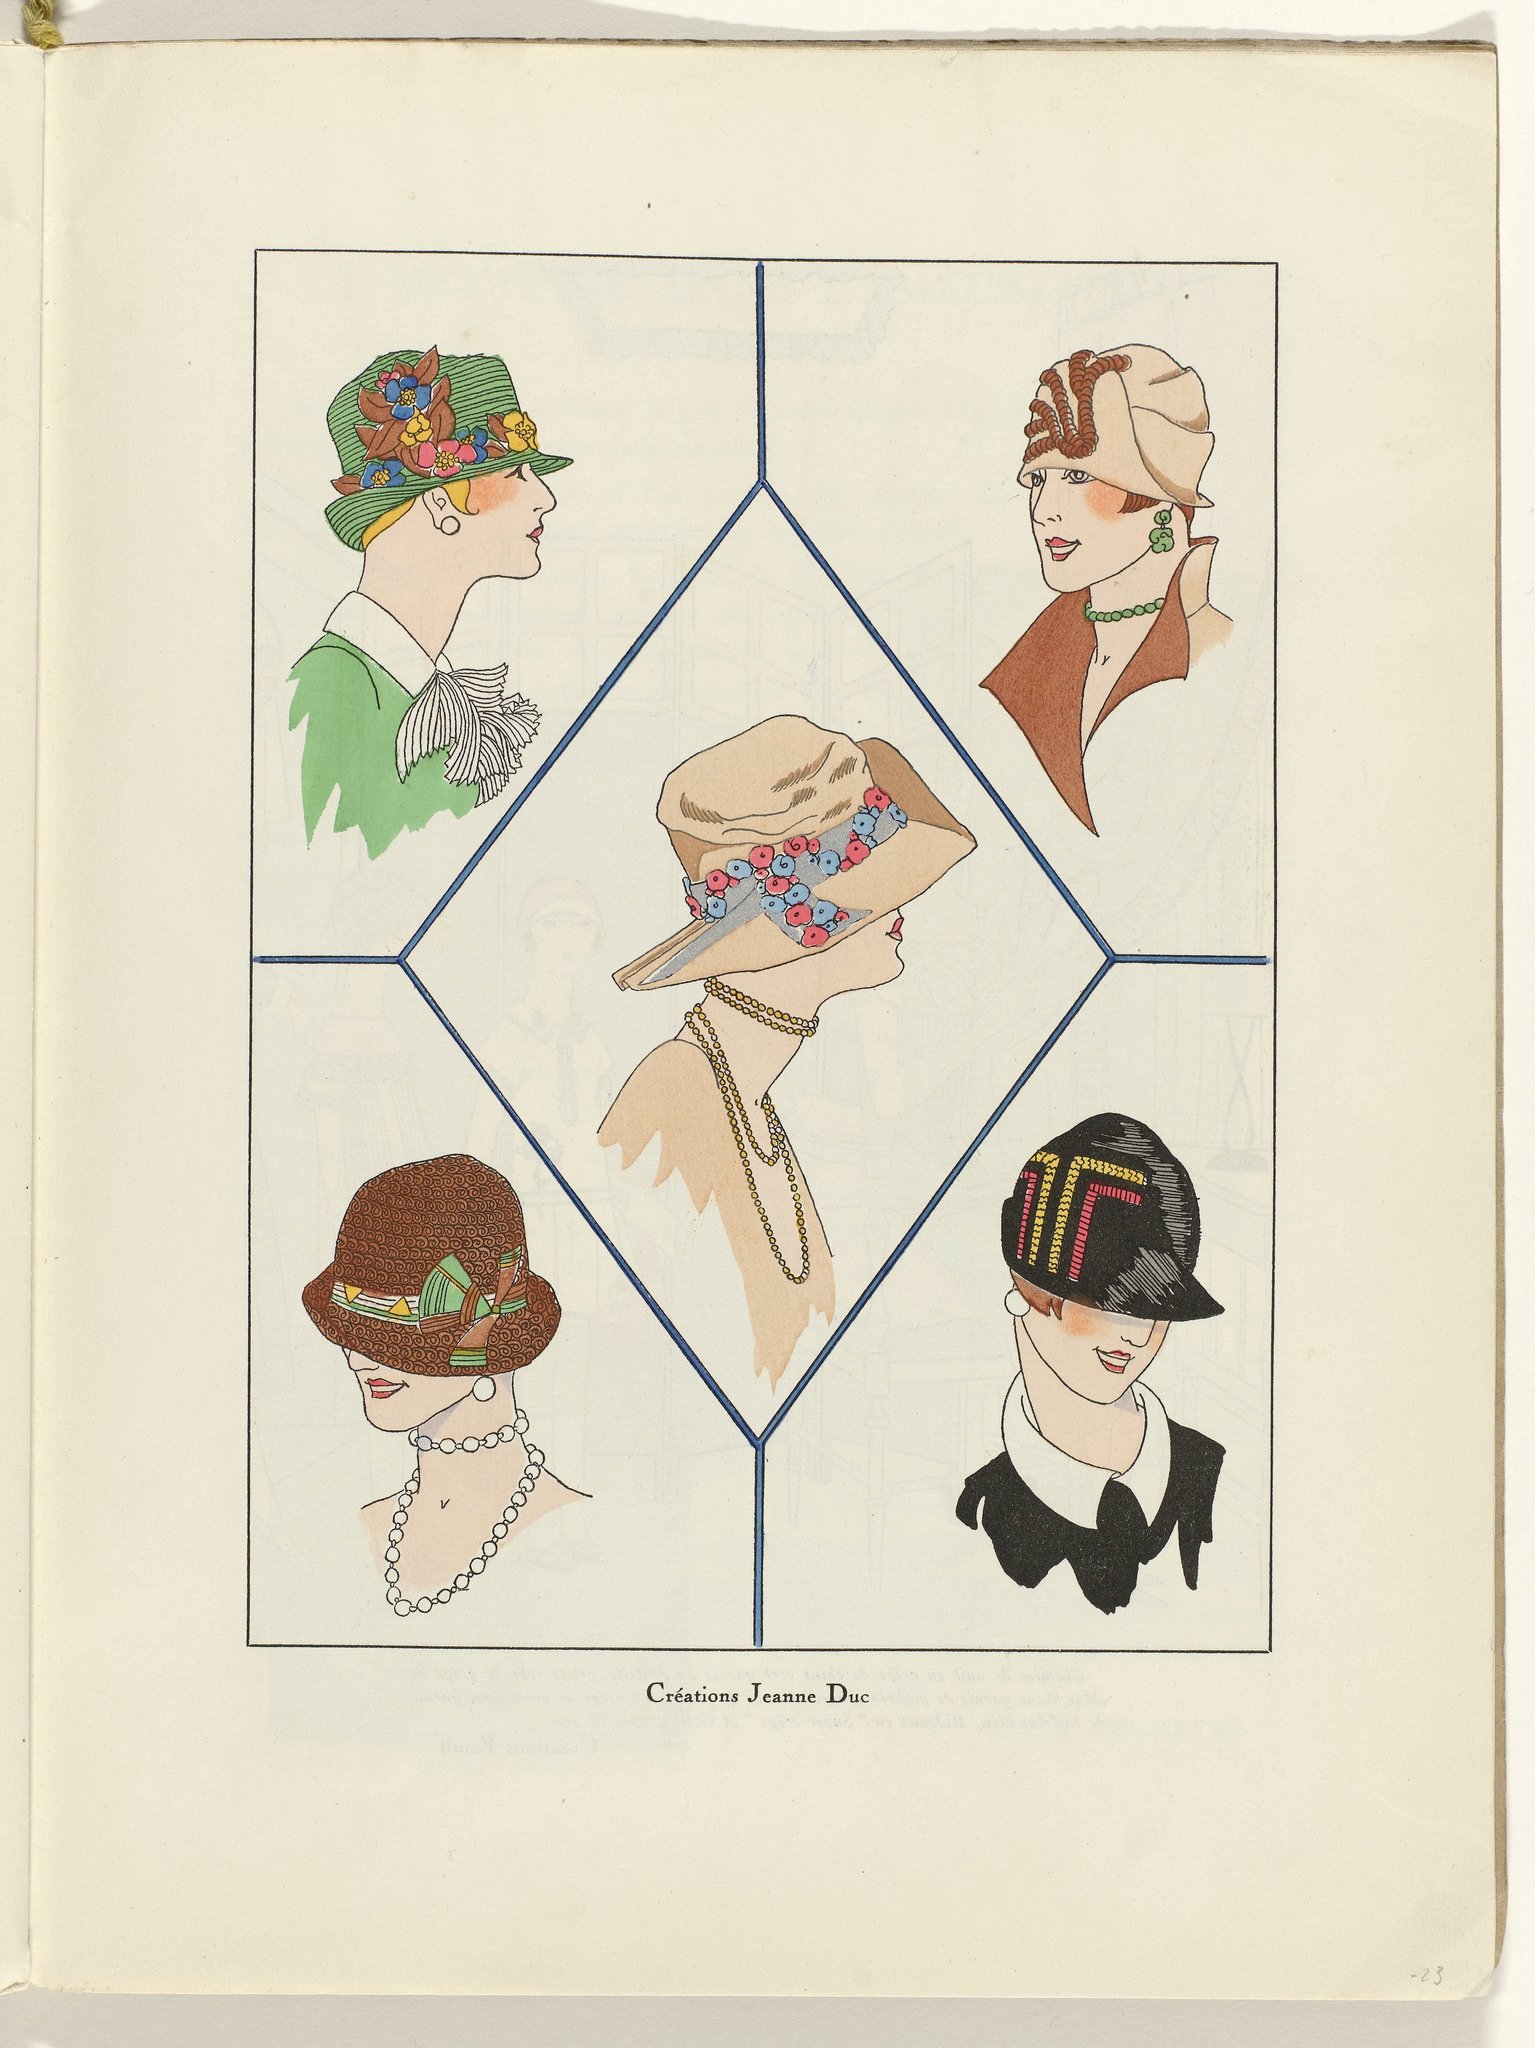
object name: magazine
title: Art - Goût - Beauté, Feuillets de l' élégance féminine, Février 1926, No. 66, 6e Année, p. 23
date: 1926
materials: paper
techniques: brush, hand coloring, lithograph, pochoir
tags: fashion plates, head-gear: hat (+ women's clothes)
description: Vijf verschillende dameshoeden van Jeanne Duc. Pagina uit het modetijdschrift Art-Goût-Beauté (1920-1933).